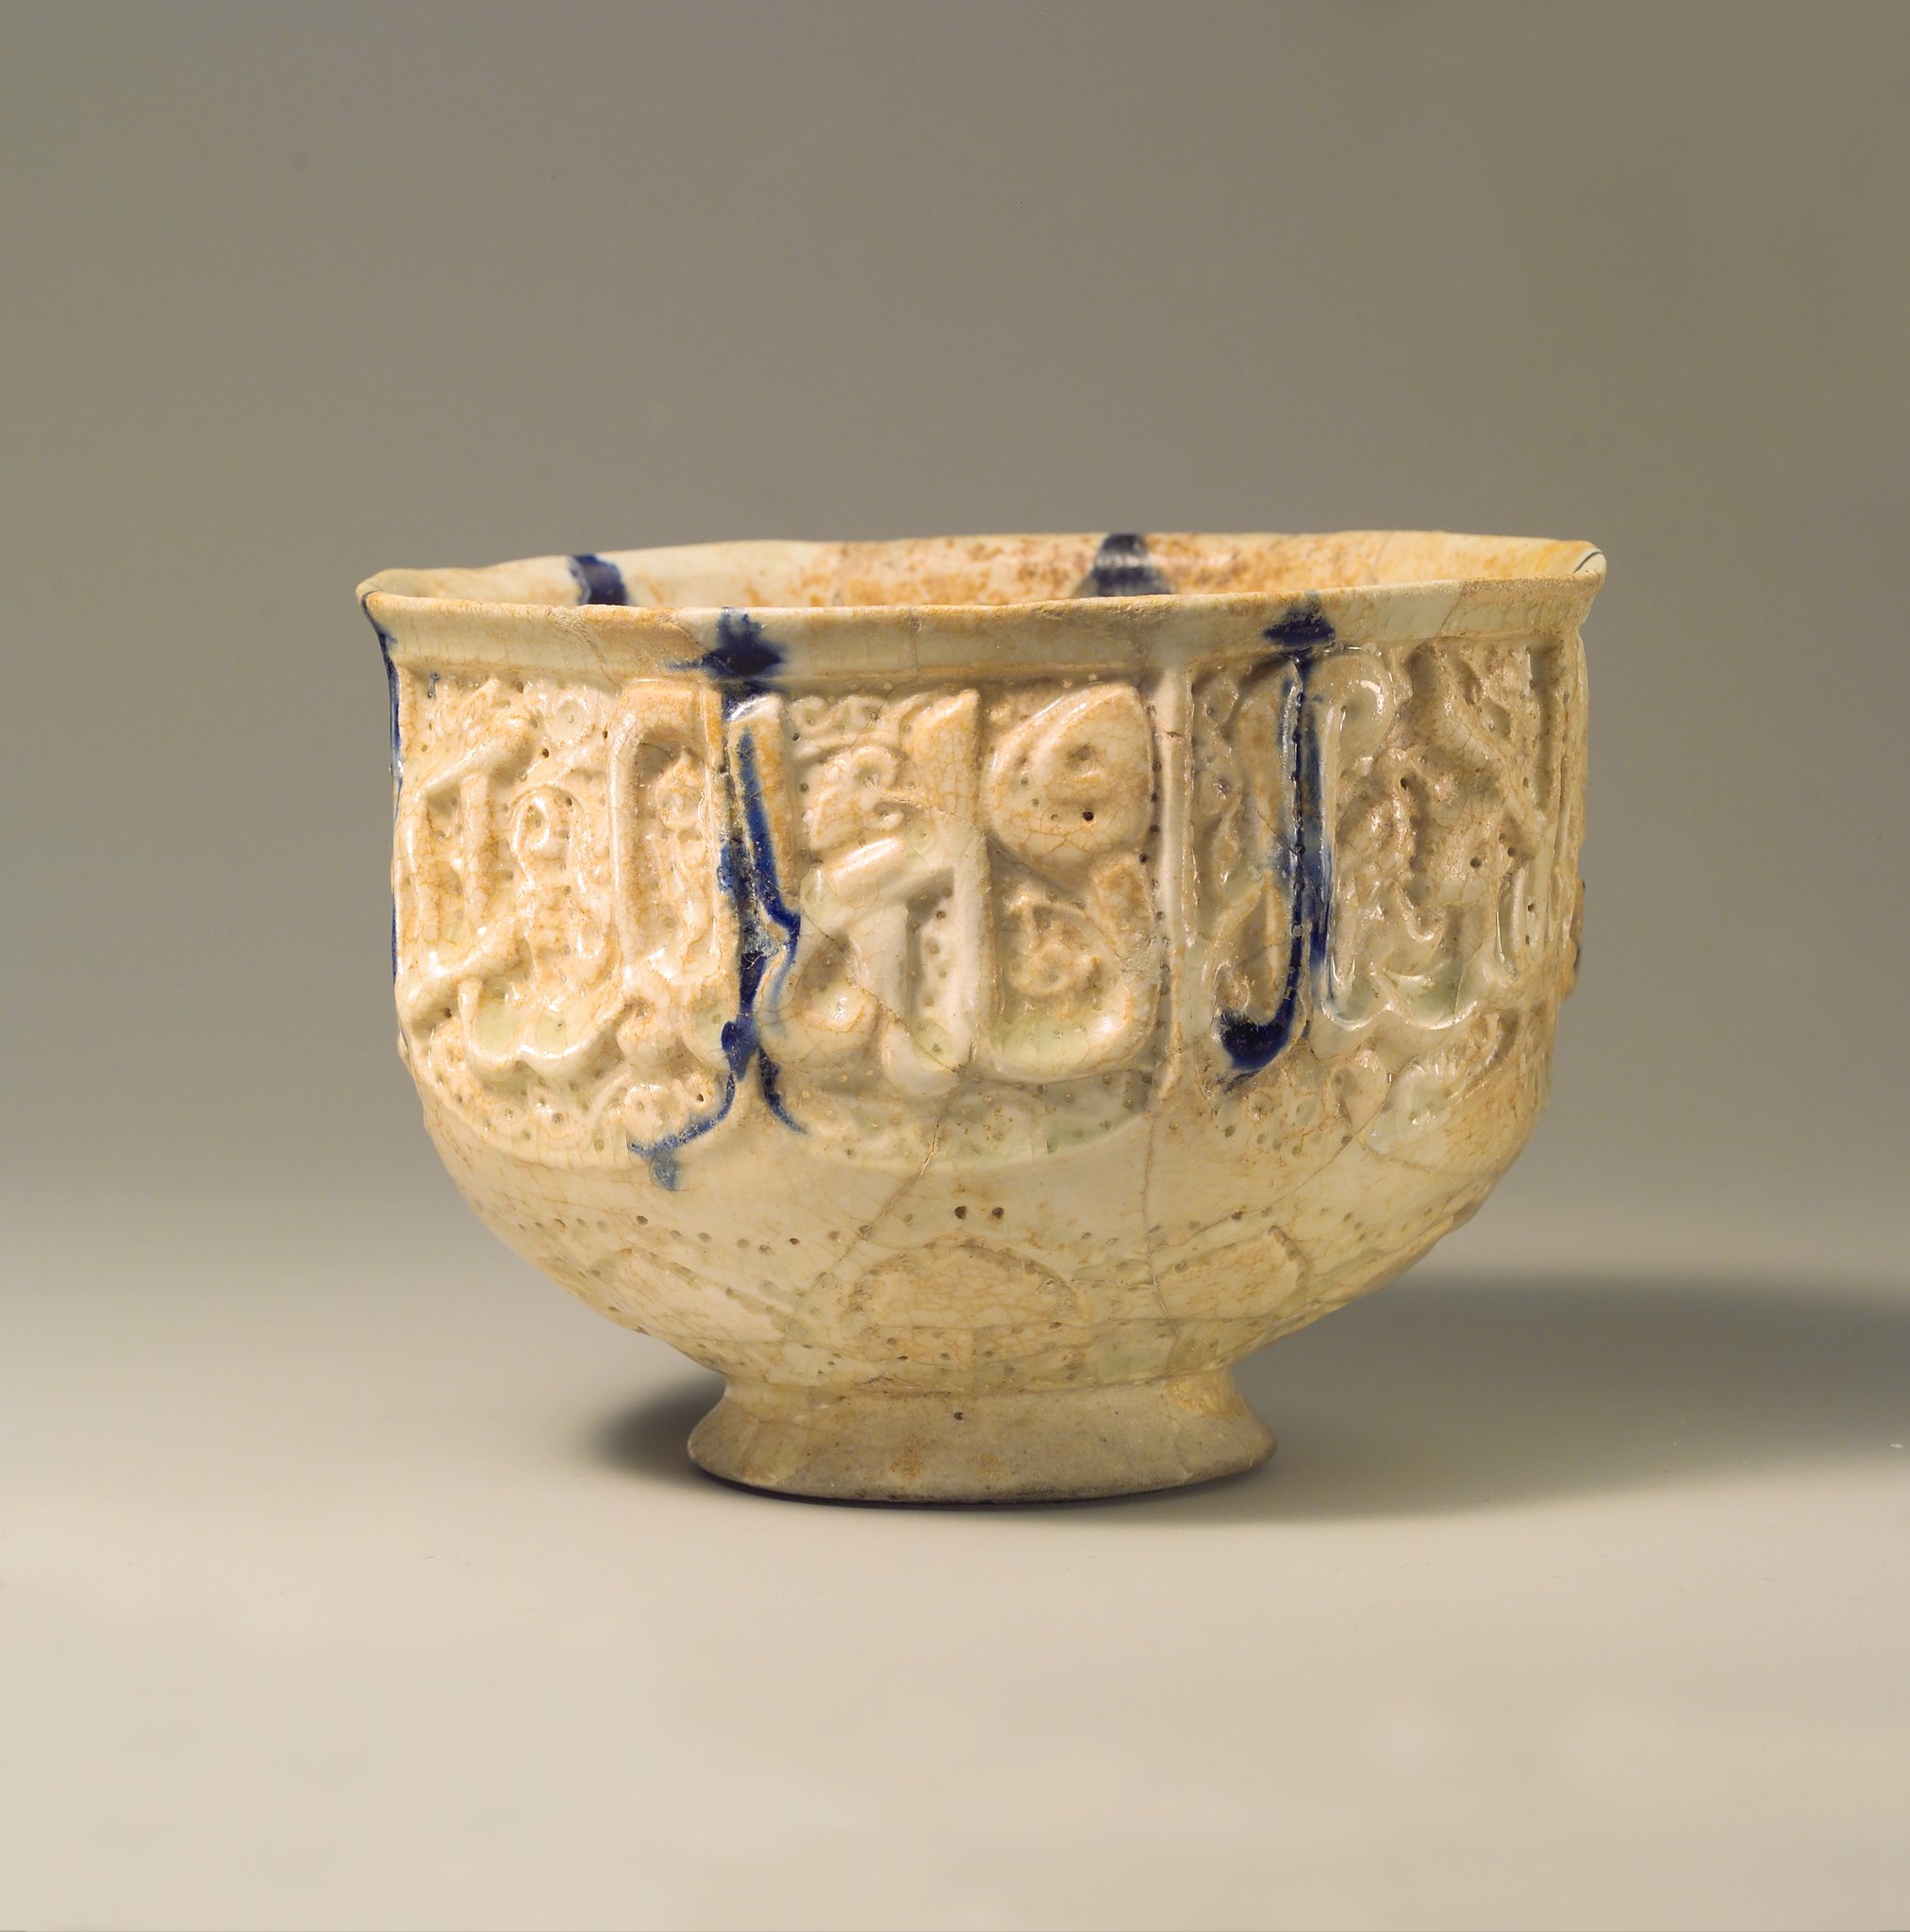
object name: bowl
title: Pierced Bowl Signed by Hasan al-Qashani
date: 1067-1133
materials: glaze, stonepaste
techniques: molding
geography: iran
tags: arabic